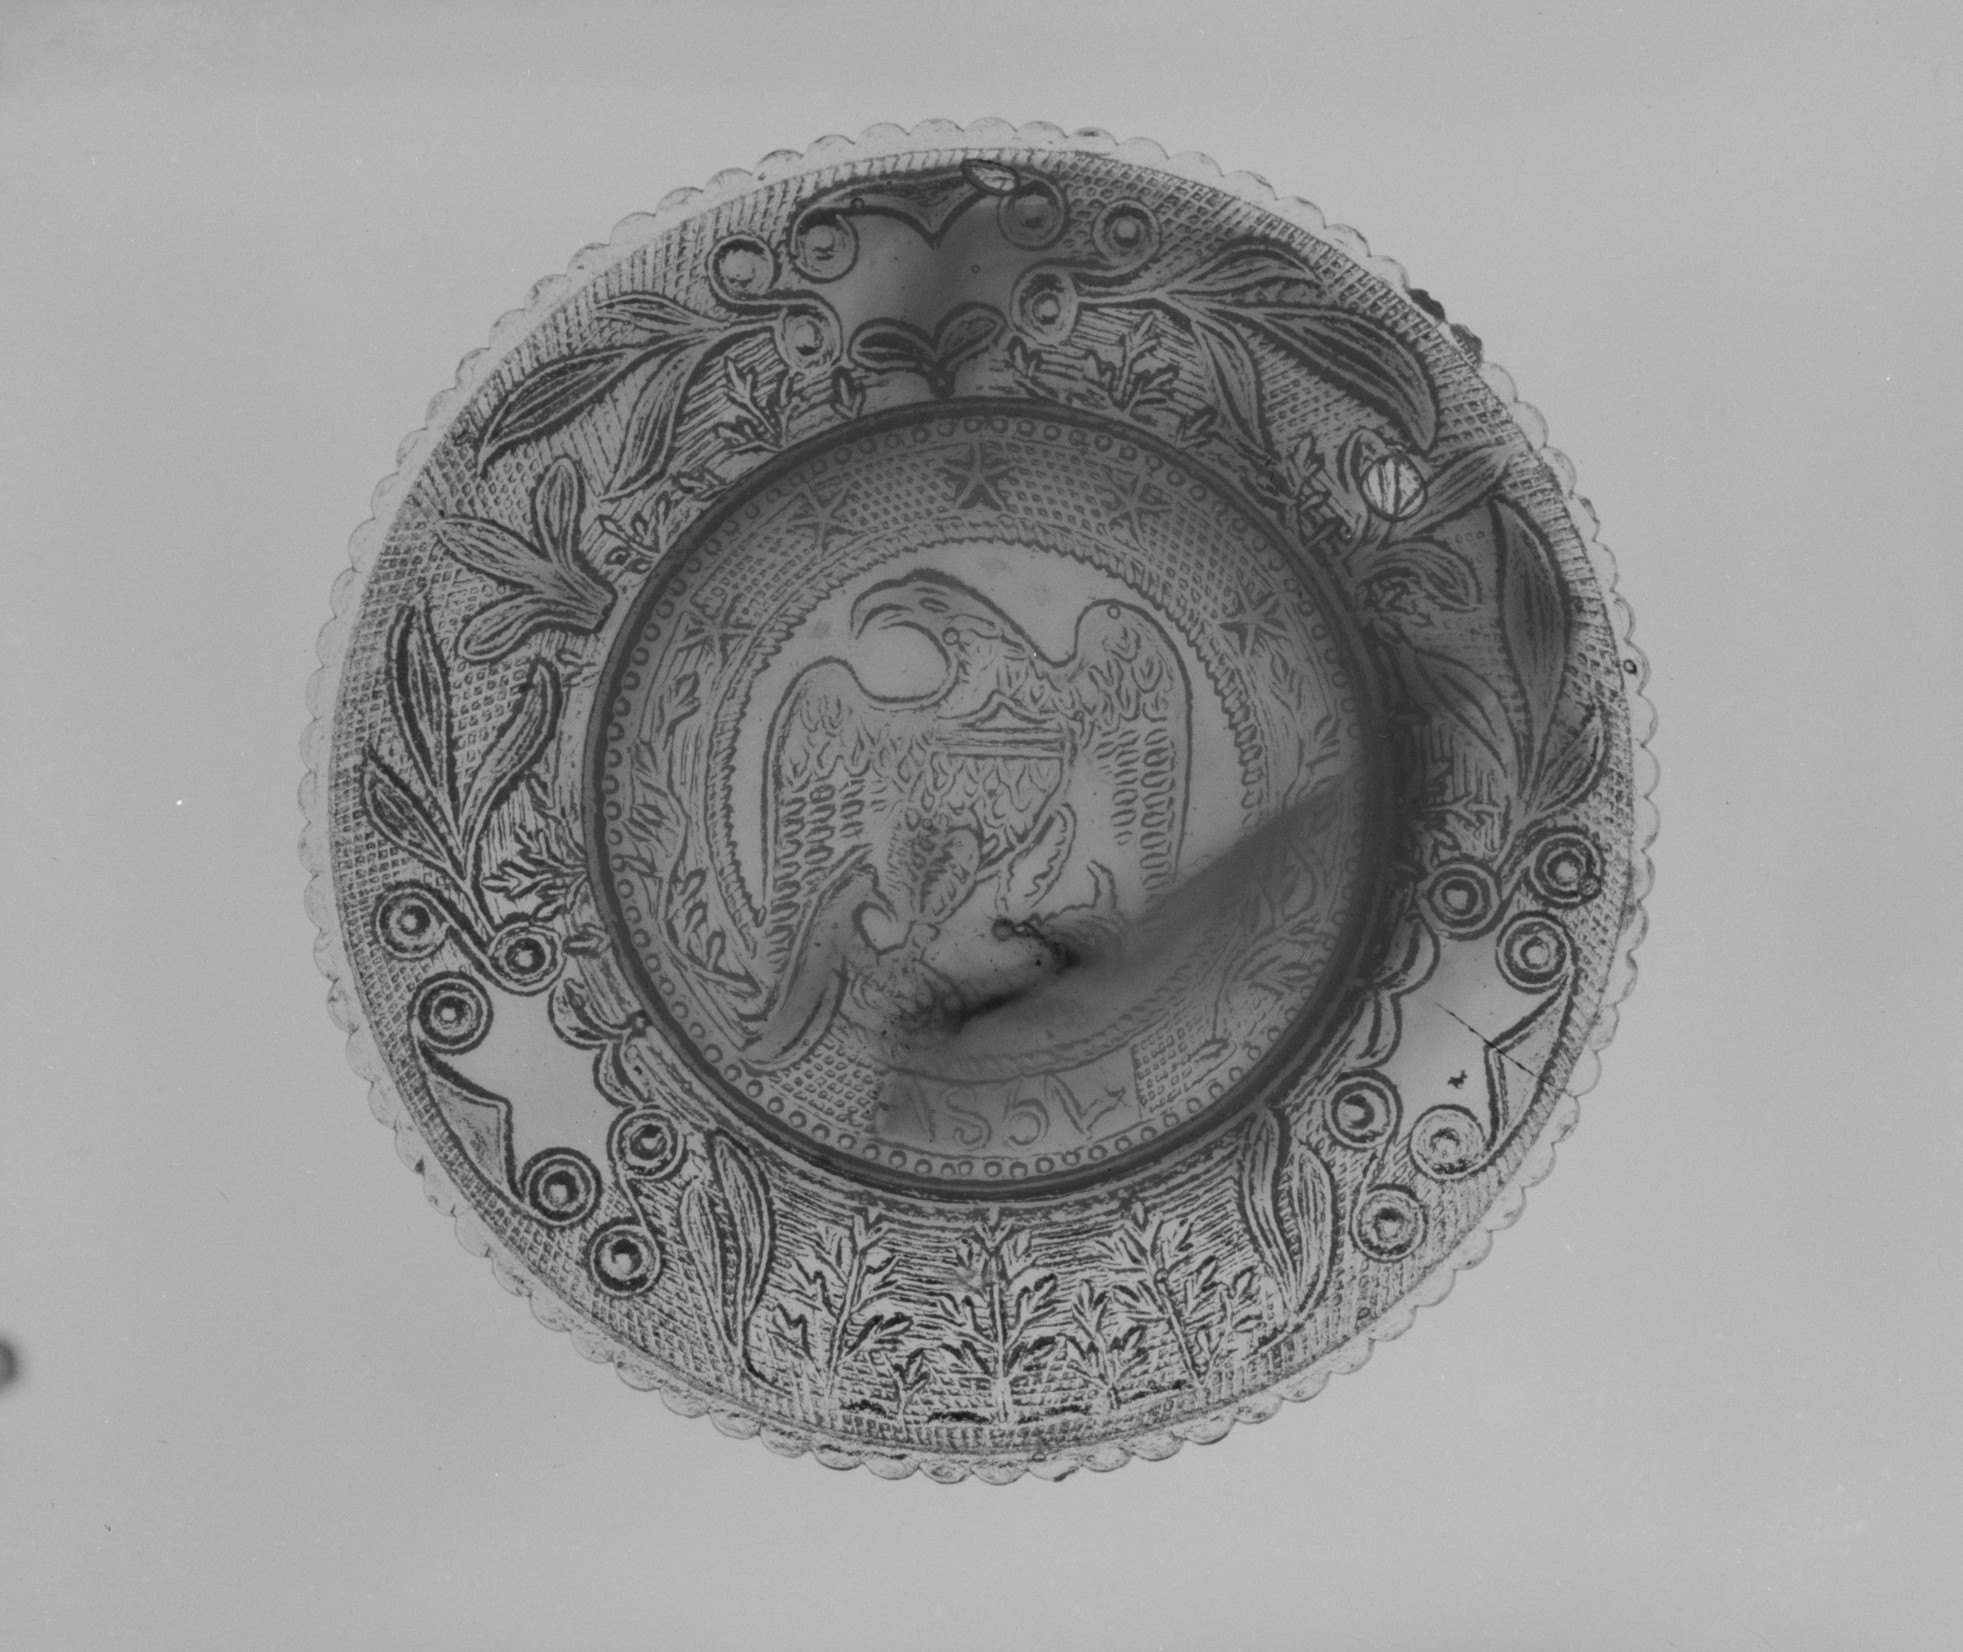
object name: cup plate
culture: american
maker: boston & sandwich glass company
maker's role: maker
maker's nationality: american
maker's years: 1825-1888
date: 1832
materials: glass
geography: united states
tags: eagles